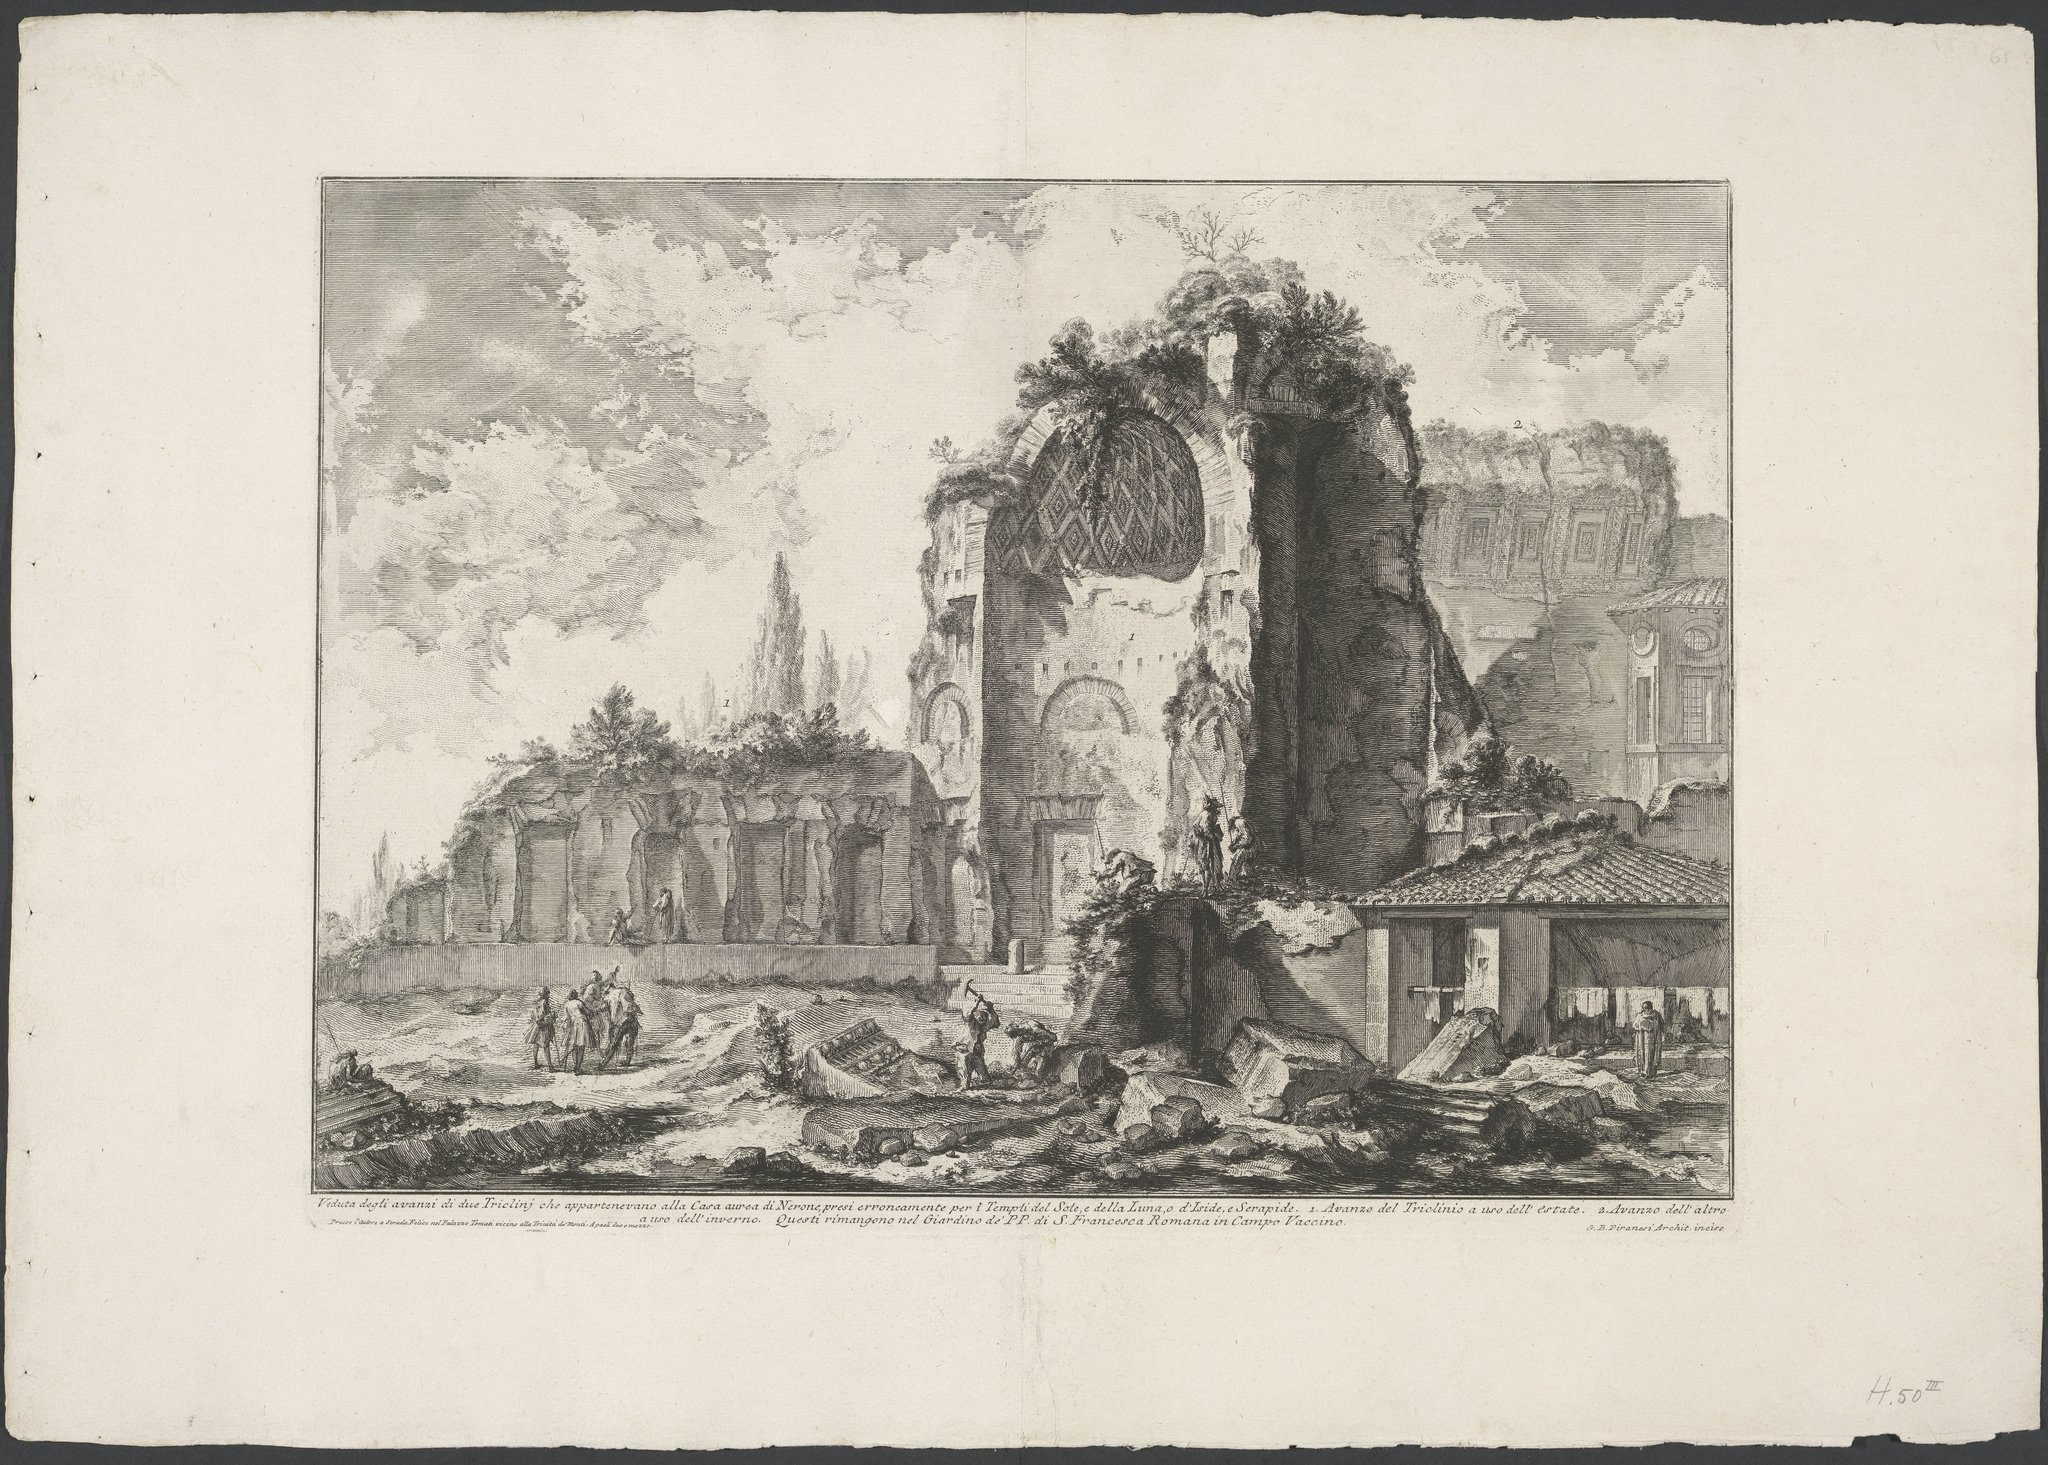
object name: print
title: Tempel van Venus en Roma te Rome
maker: giovanni battista piranesi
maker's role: designer, draughtsman, print maker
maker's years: 1720-1778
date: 1748-1778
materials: paper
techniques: etching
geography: rome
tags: ruin of a building ~ architecture, landscape with ruins, temple, shrine ~ roman religion, rome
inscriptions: collector's mark: Lugt 2228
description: Deze prent maakt deel uit van de serie 'Vedute di Roma'. Piranesi werkte aan deze 135 platen tellende serie tussen 1748 en zijn dood in 1778. Francesco Piranesi voegde later nog twee prenten toe aan de reeks van zijn vader.